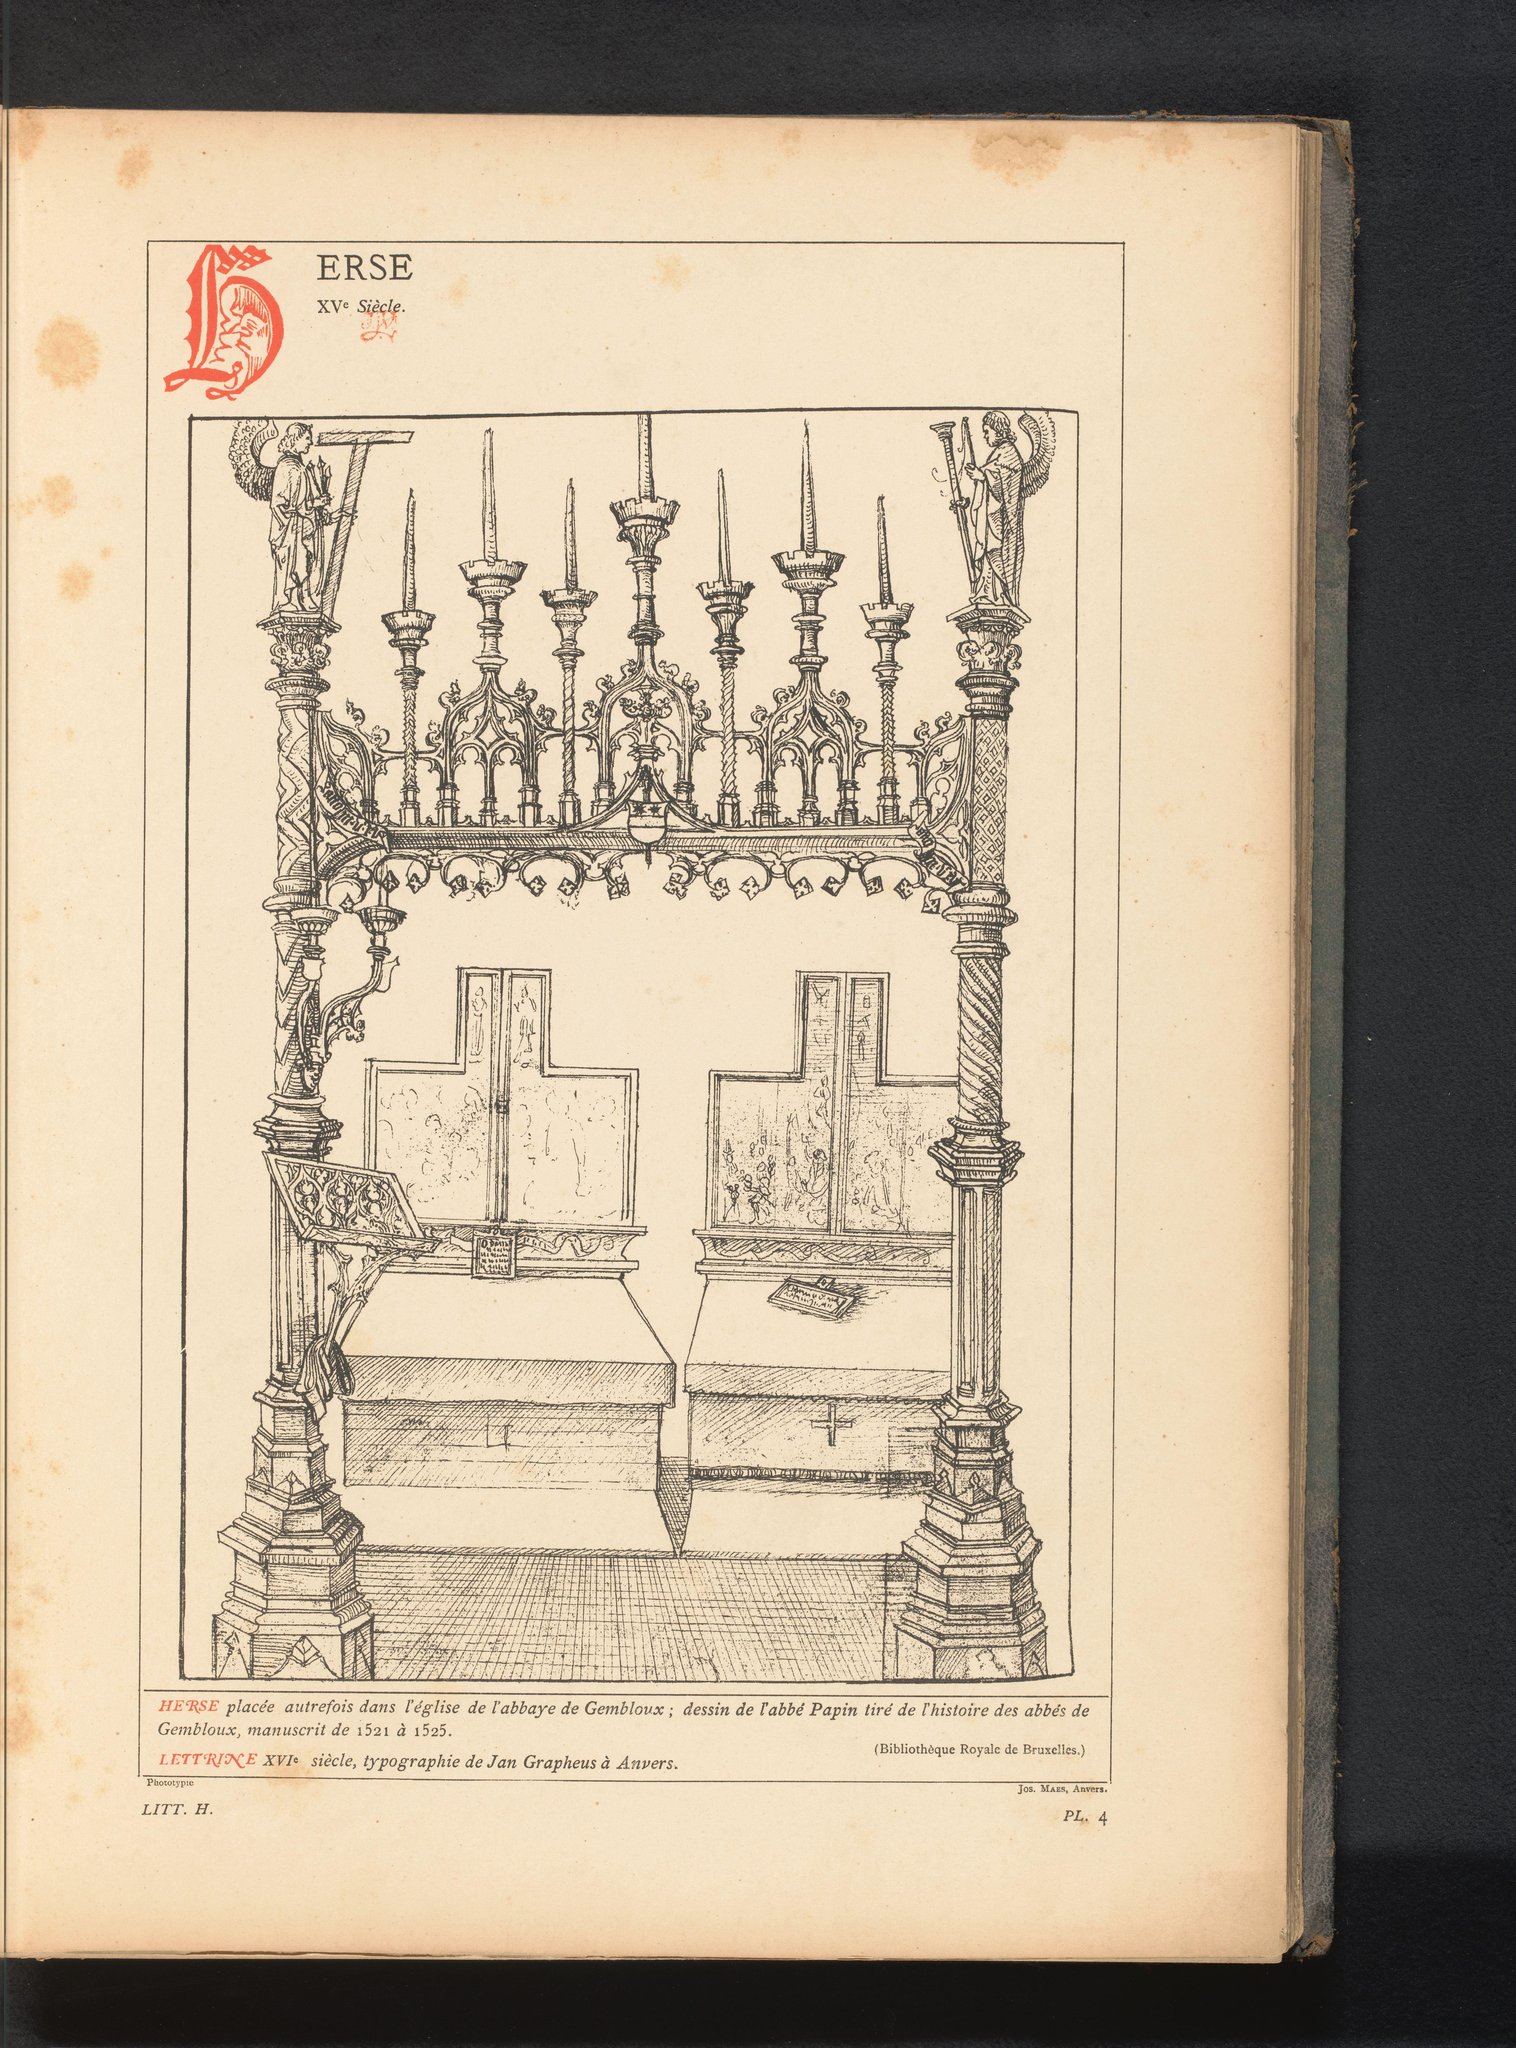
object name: page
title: Reproductie van een prent van een koorhek in de abdij van Gembloers, getekend door de abt Antoine Papin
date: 1875-1880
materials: paper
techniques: photolithography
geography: antwerp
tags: parts of church interior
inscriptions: inscription: ‘HERSE placée autrefois (...)’, monogram: ‘JJvY’, inscription: ‘LITT. H. - PL. 4’